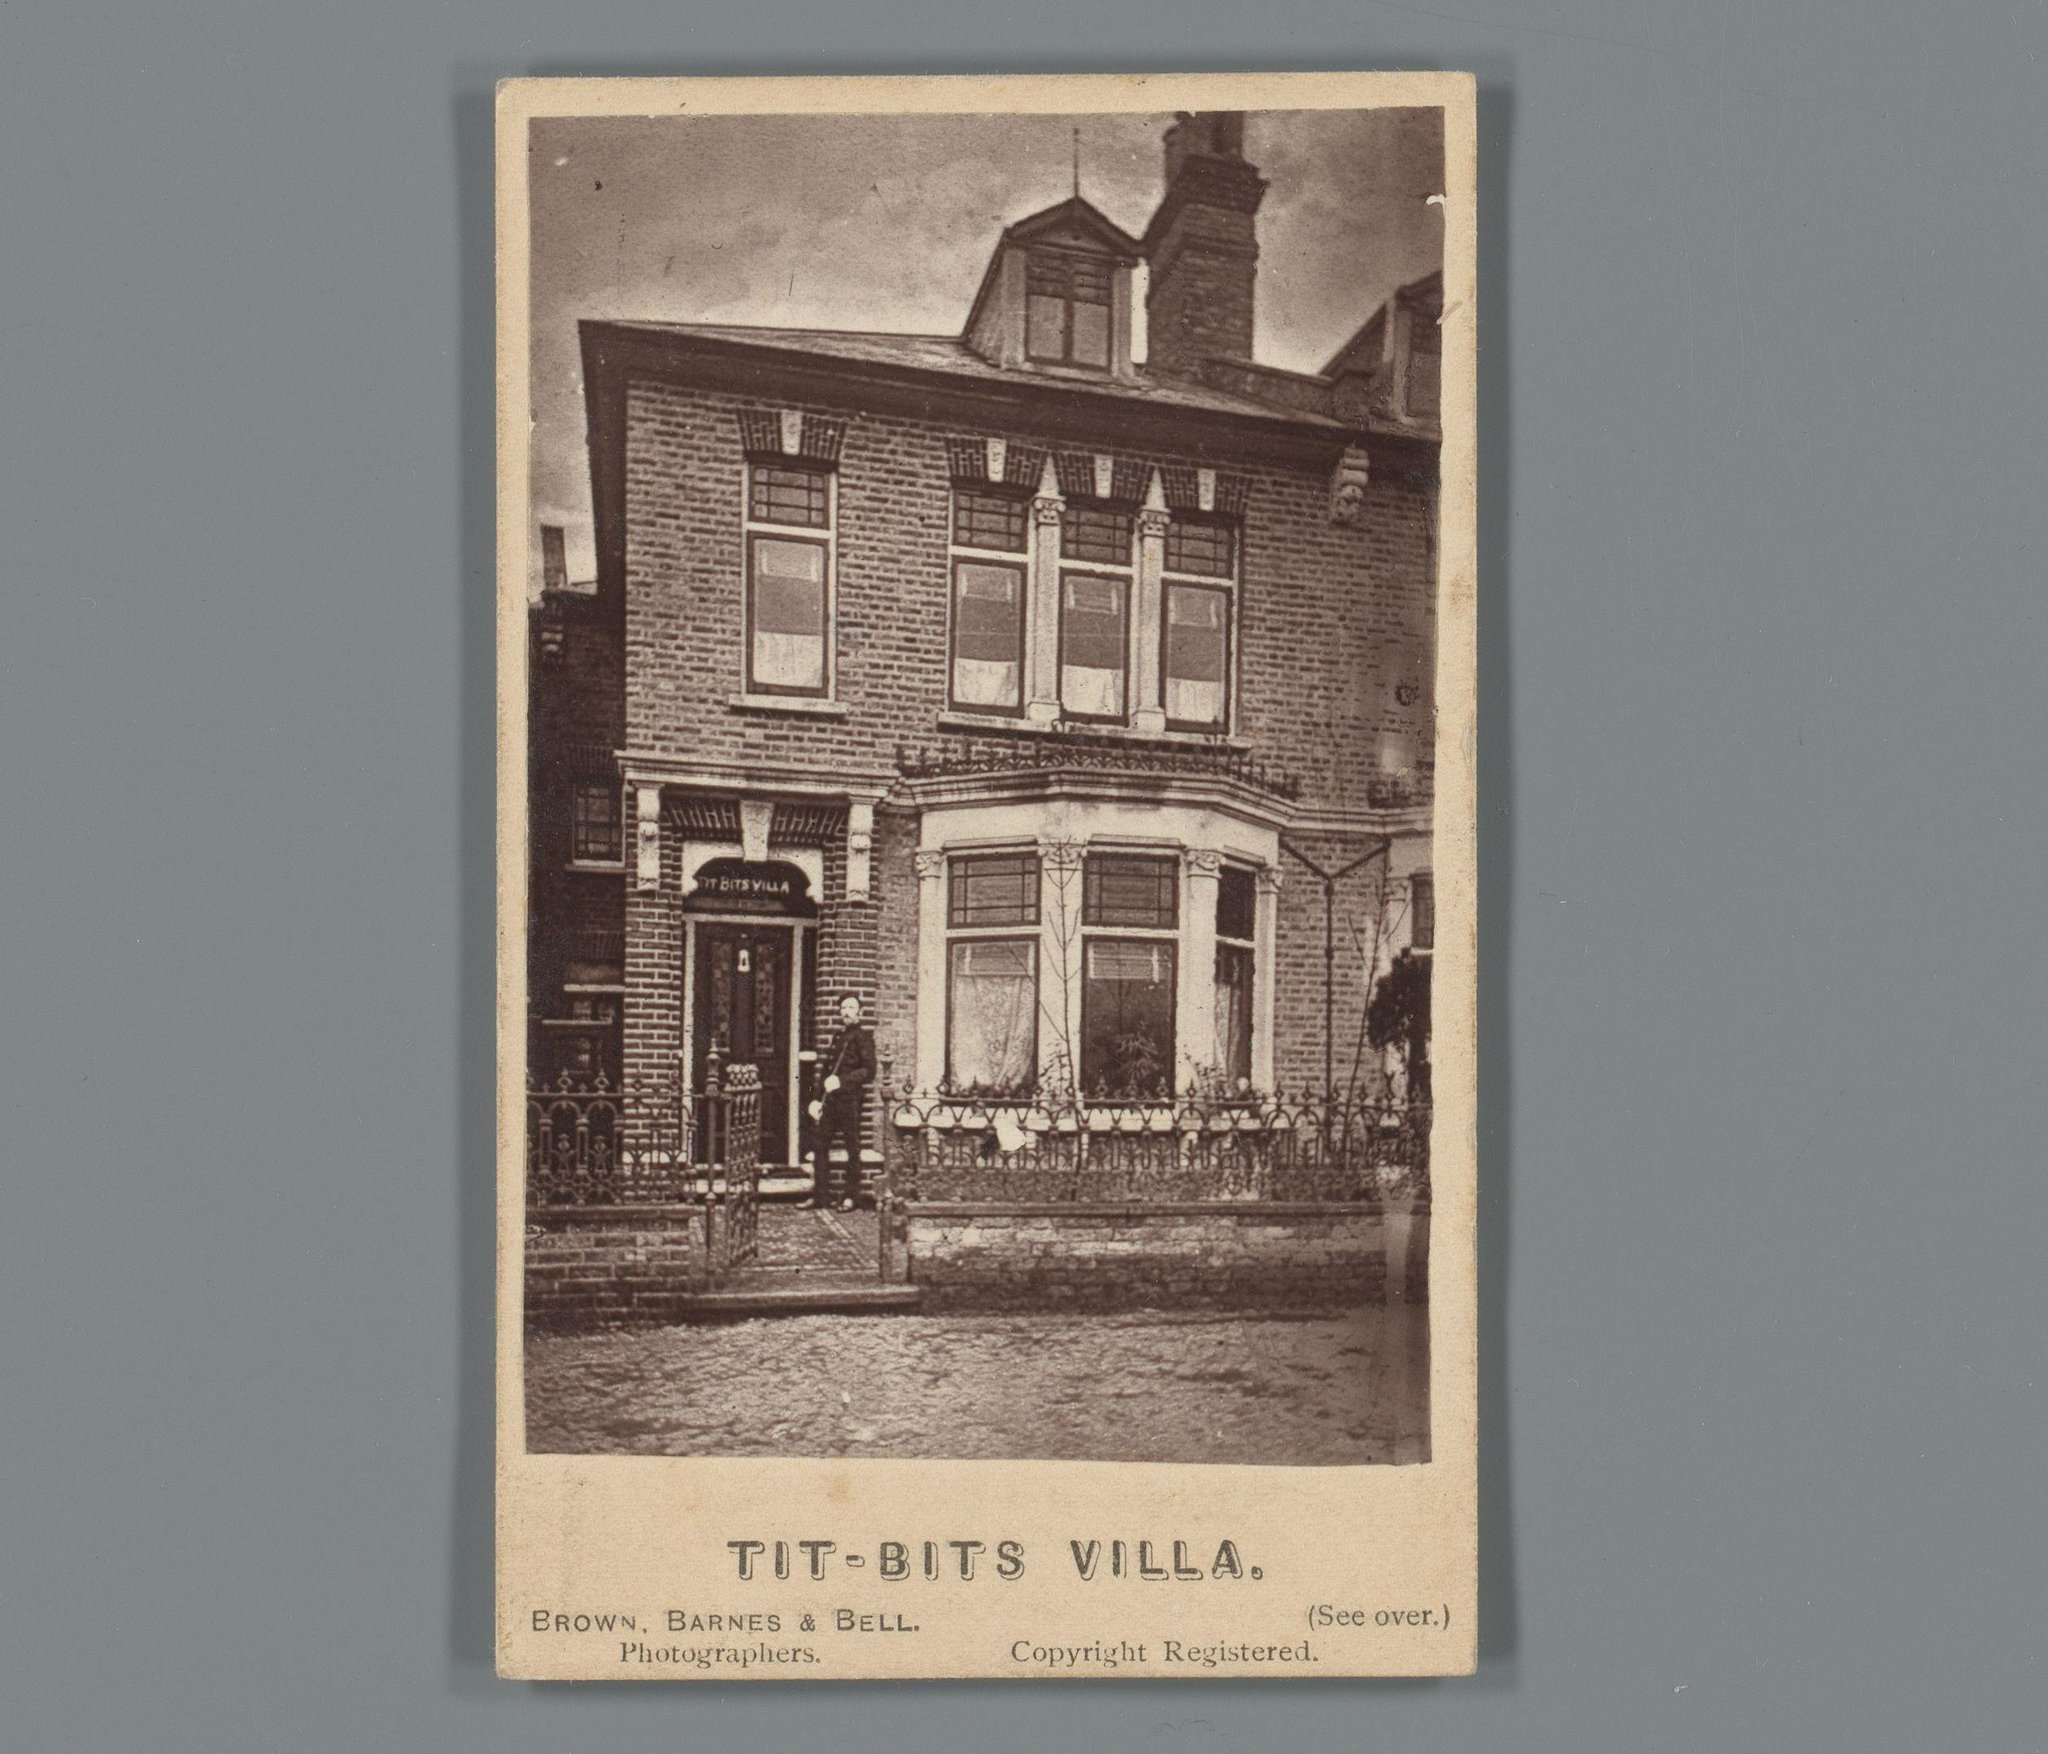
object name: carte de visite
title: Gezicht op de Londense woning gewonnen door William Robert Mellish voor zijn inzending bij tijdschrift Tit-Bits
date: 1883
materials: cardboard, photographic support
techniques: carbon print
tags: advertising, historical persons, the usual house or row of houses, competition, art contest, london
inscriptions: inscription: ‘THIS VILLA WAS WON/ BY/ Private Wm. Robt. Mellish,/ of the/ 8th HUSSARS,/ in the/ TIT-BITS CHRISTMAS/ COMPETITION, 1883./ The Winner is seen standing by/ the Porch./ PERMANENT PHOTOGRAPH BY/ BROWN, BARNES & BELL,/ THE PHOTOGRAPHERS.’, inscription: ‘SPECIMEN COPY’